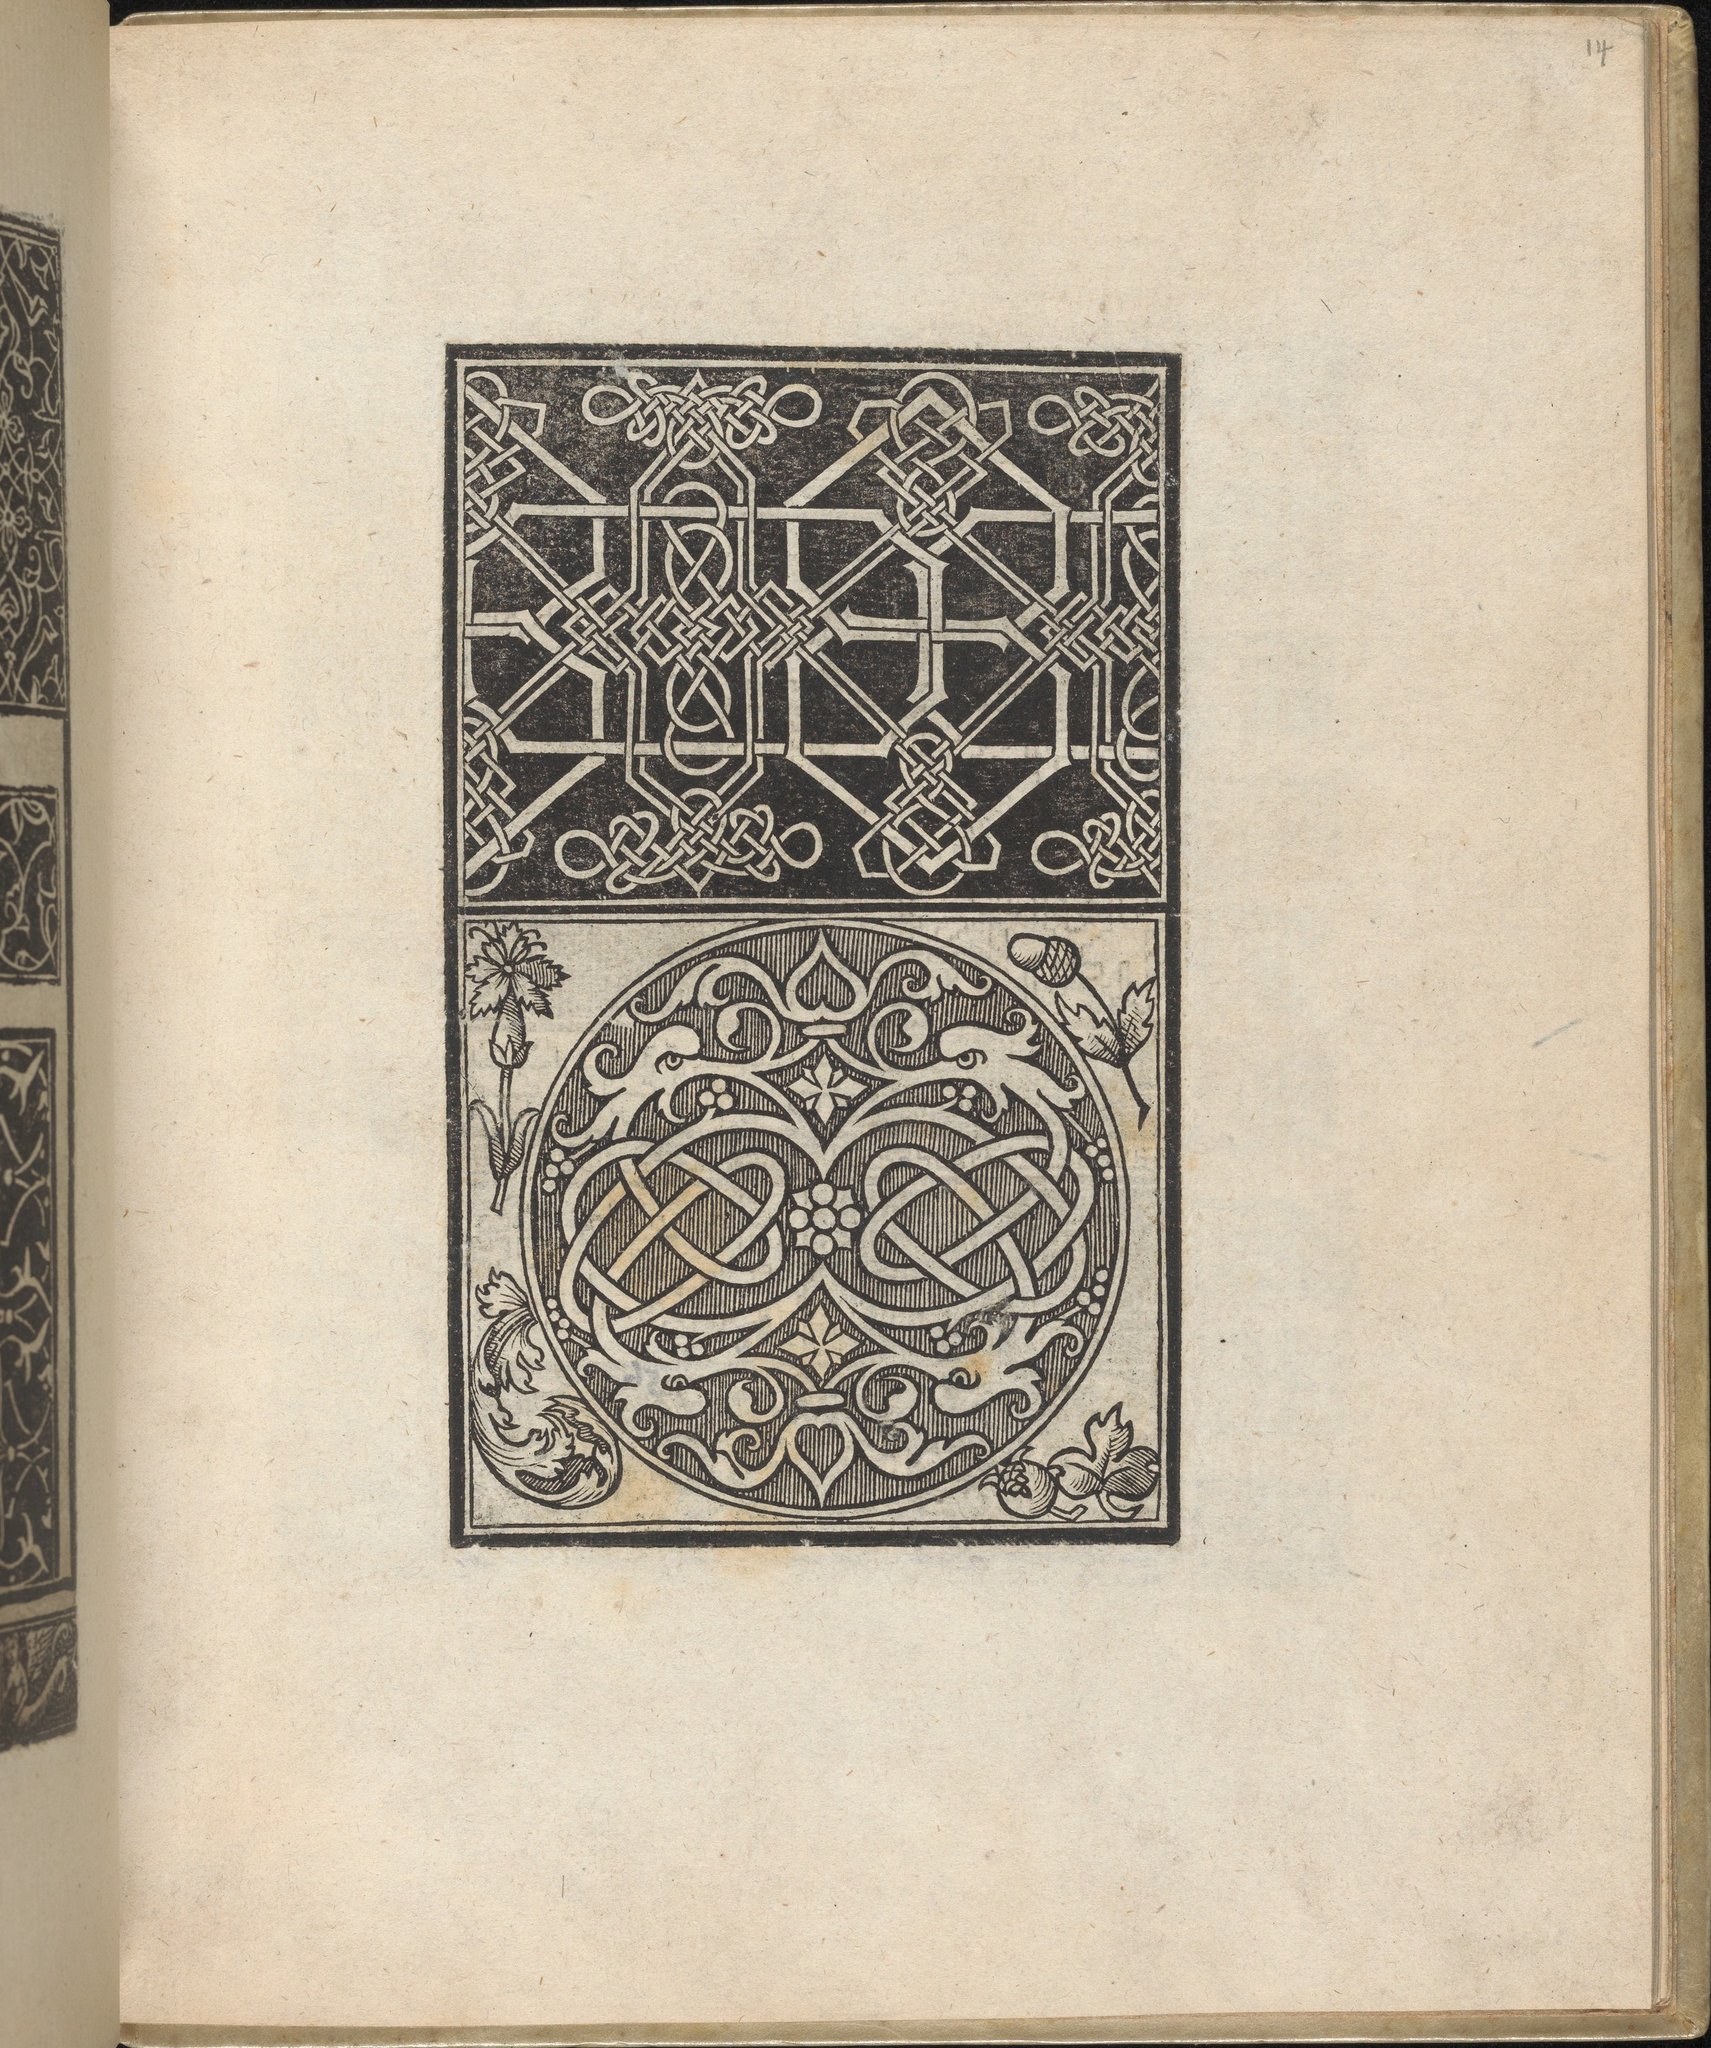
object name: book print ornament architecture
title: Trionfo Di Virtu. Libro Novo..., page 14 (verso)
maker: matteo pagano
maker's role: publisher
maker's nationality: italian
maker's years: 1515-1588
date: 1563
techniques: woodcut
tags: ornament